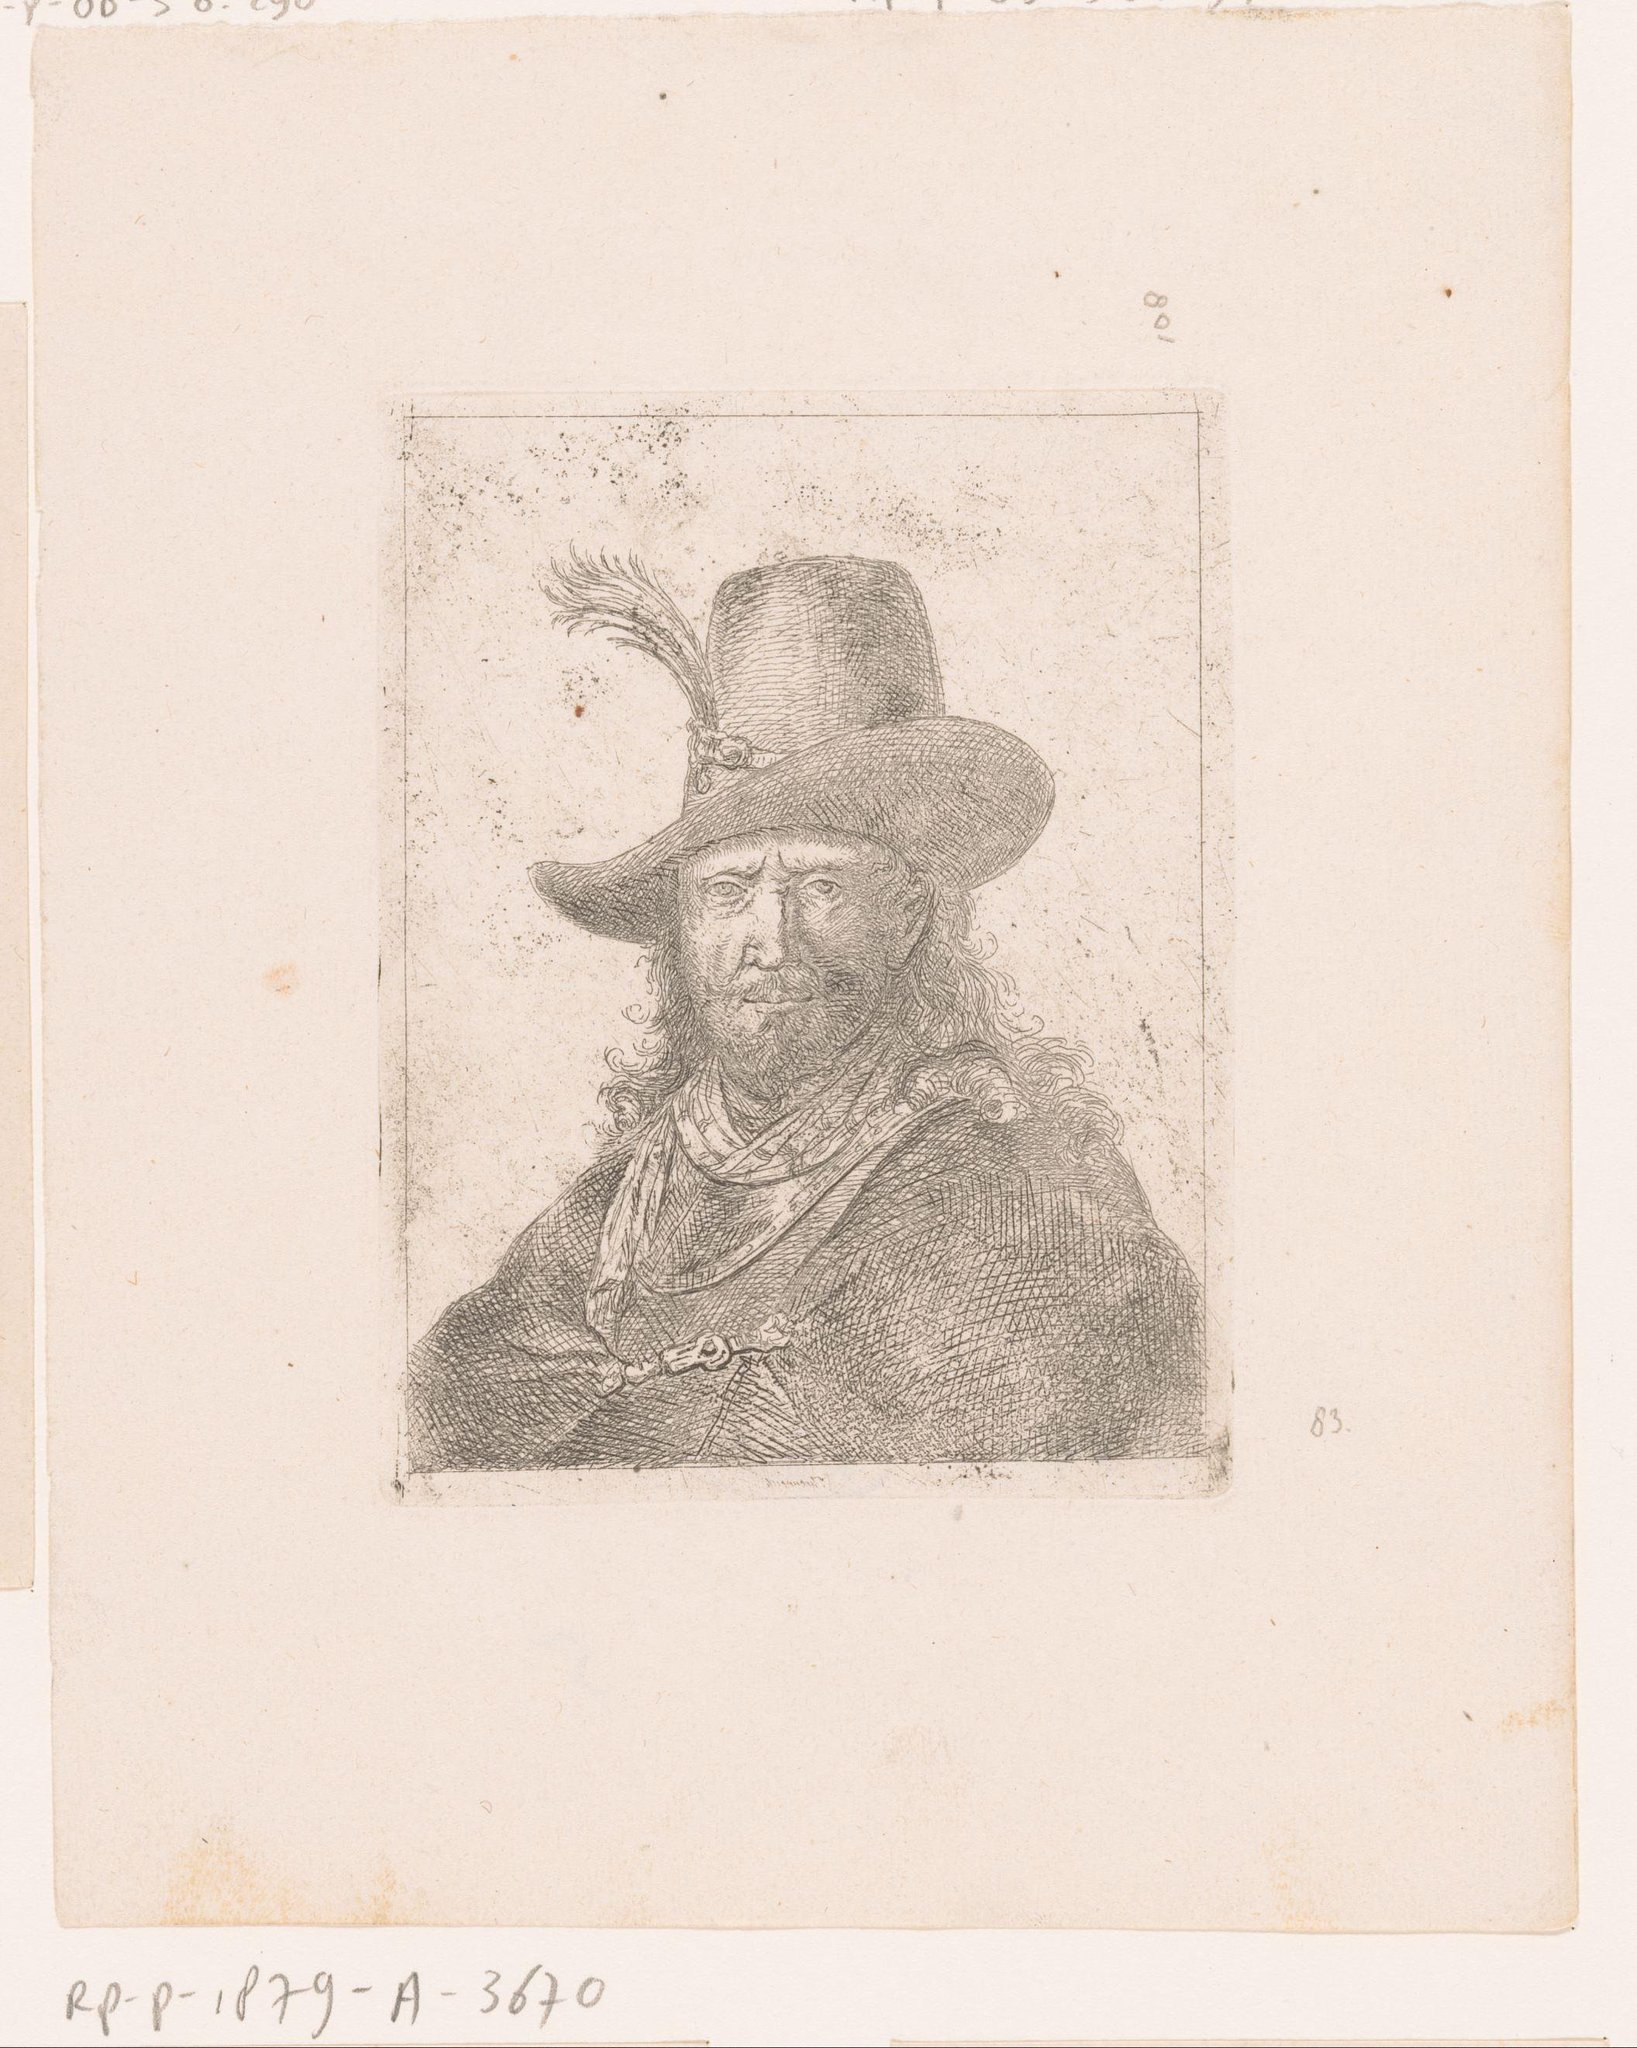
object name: print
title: Buste van man met hoge hoed met pluim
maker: Anonymous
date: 1700-1799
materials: paper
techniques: etching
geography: germany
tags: adult man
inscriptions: collector's mark: Lugt 2228